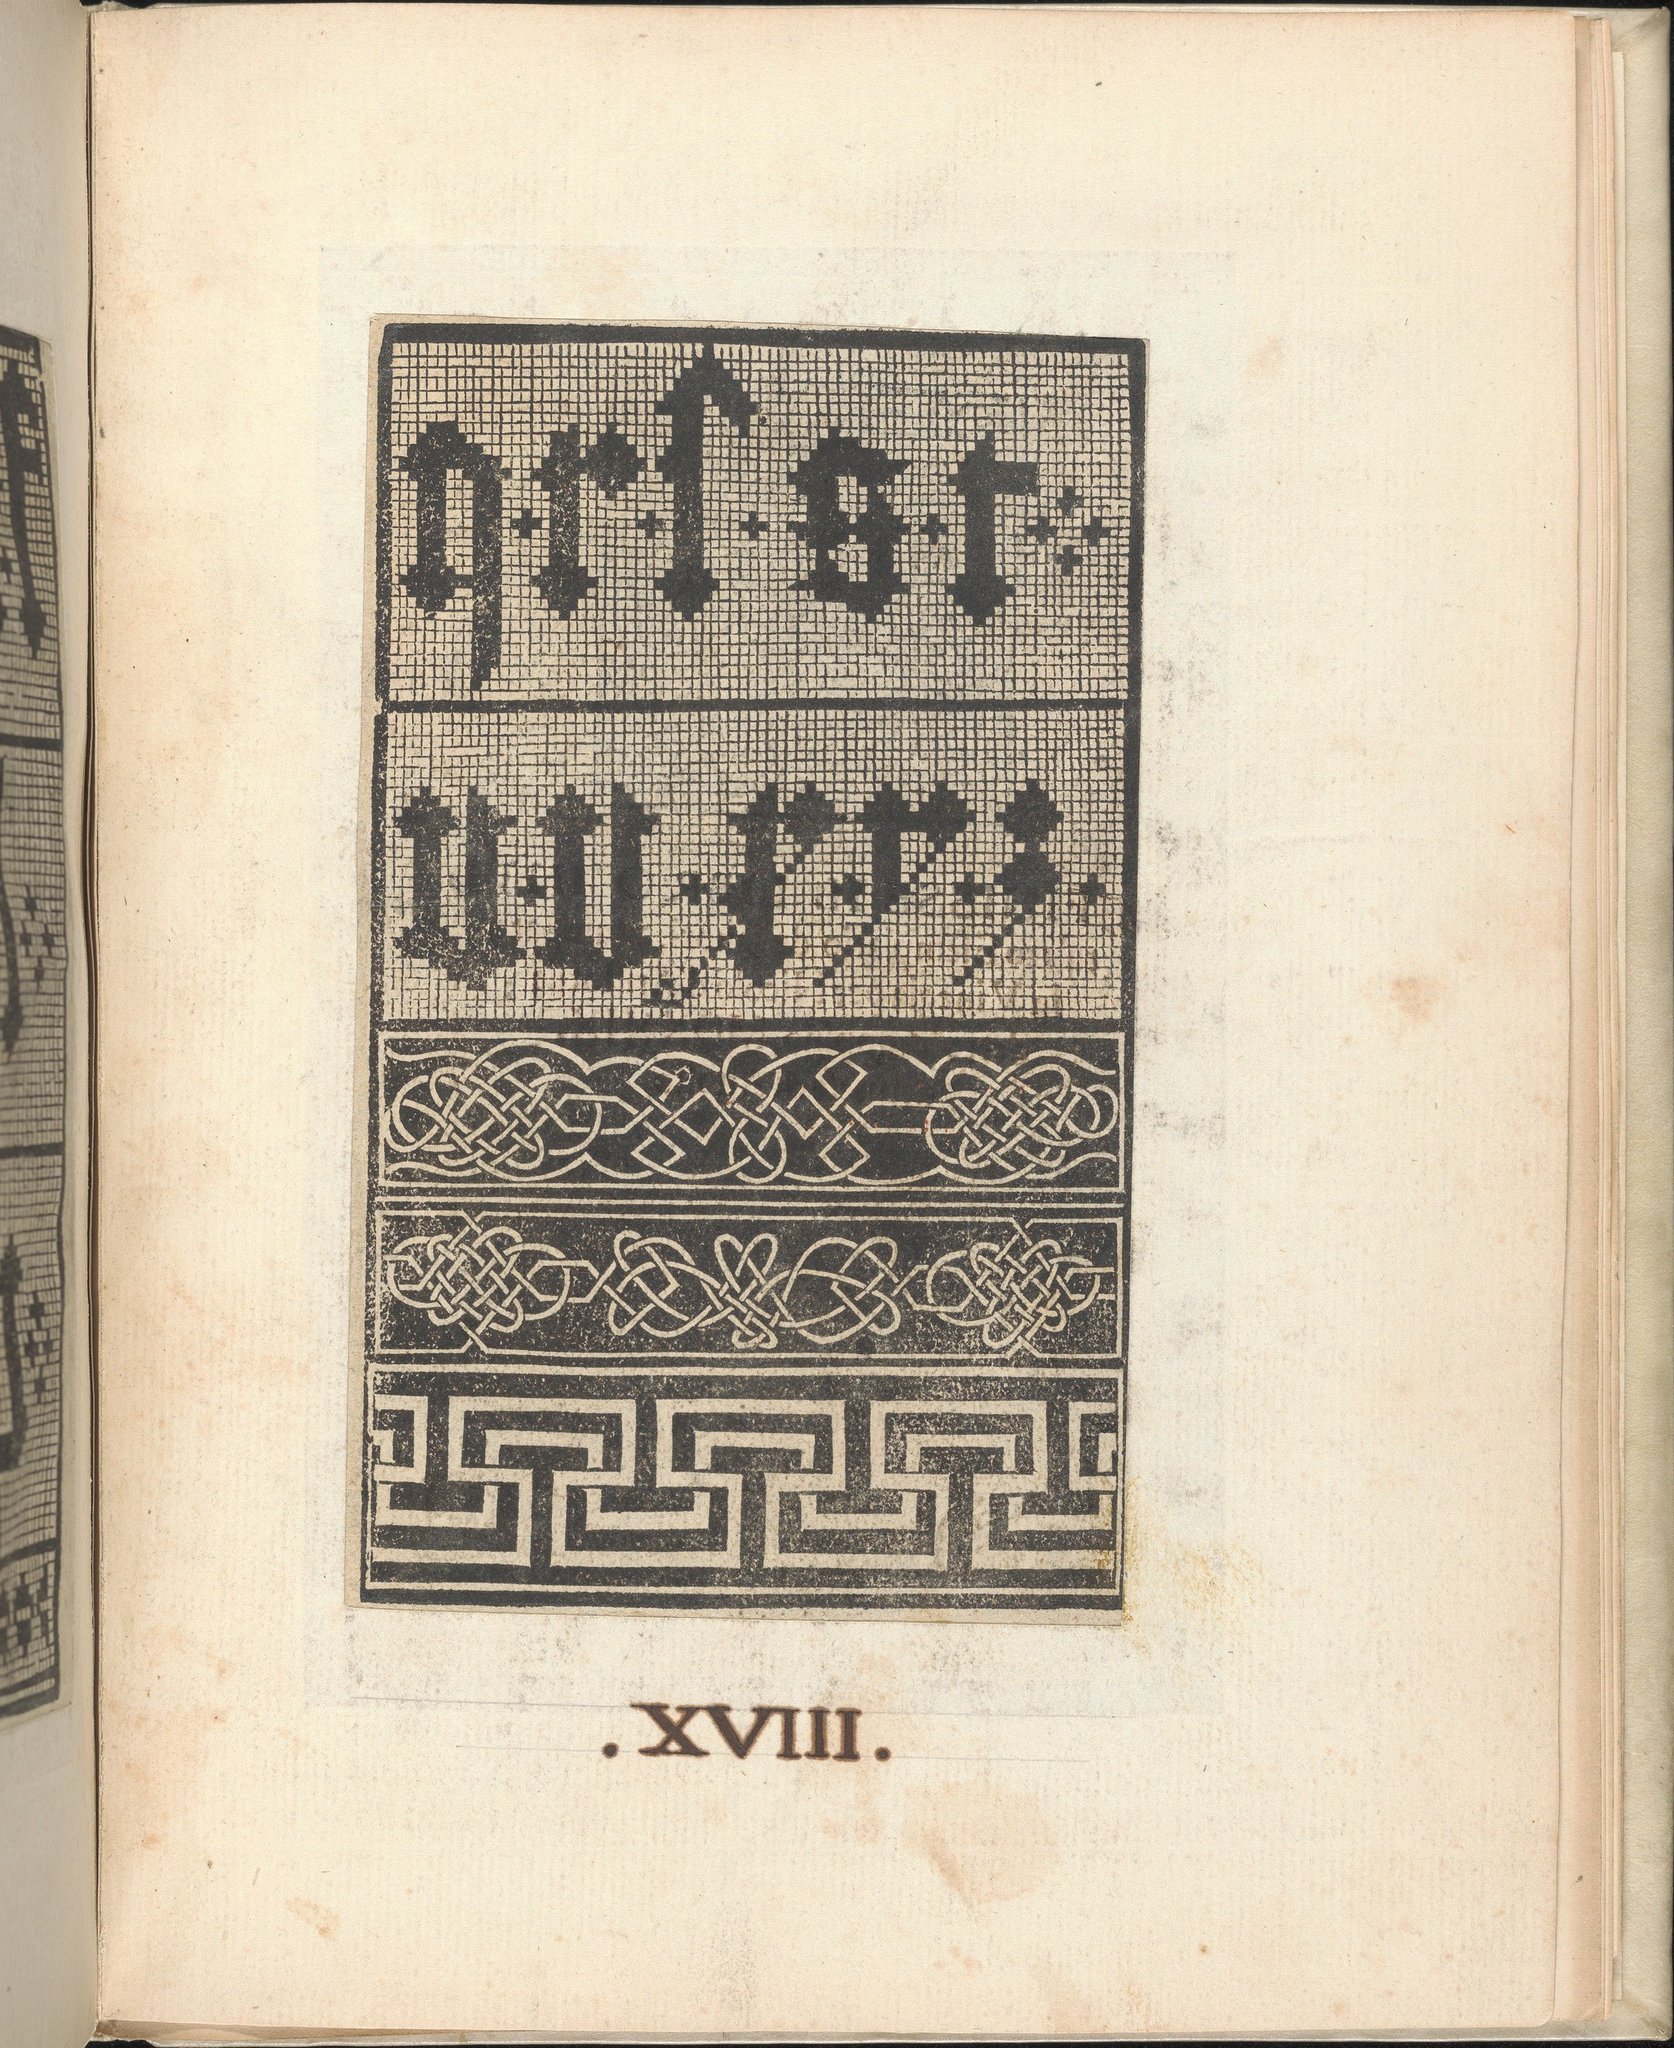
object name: book print ornament architecture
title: Esemplario di lavori, page 17 (verso)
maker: nicolò zoppino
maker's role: publisher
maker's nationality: italian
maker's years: 1478-1544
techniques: bookbinding, inlay, woodcut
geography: italy